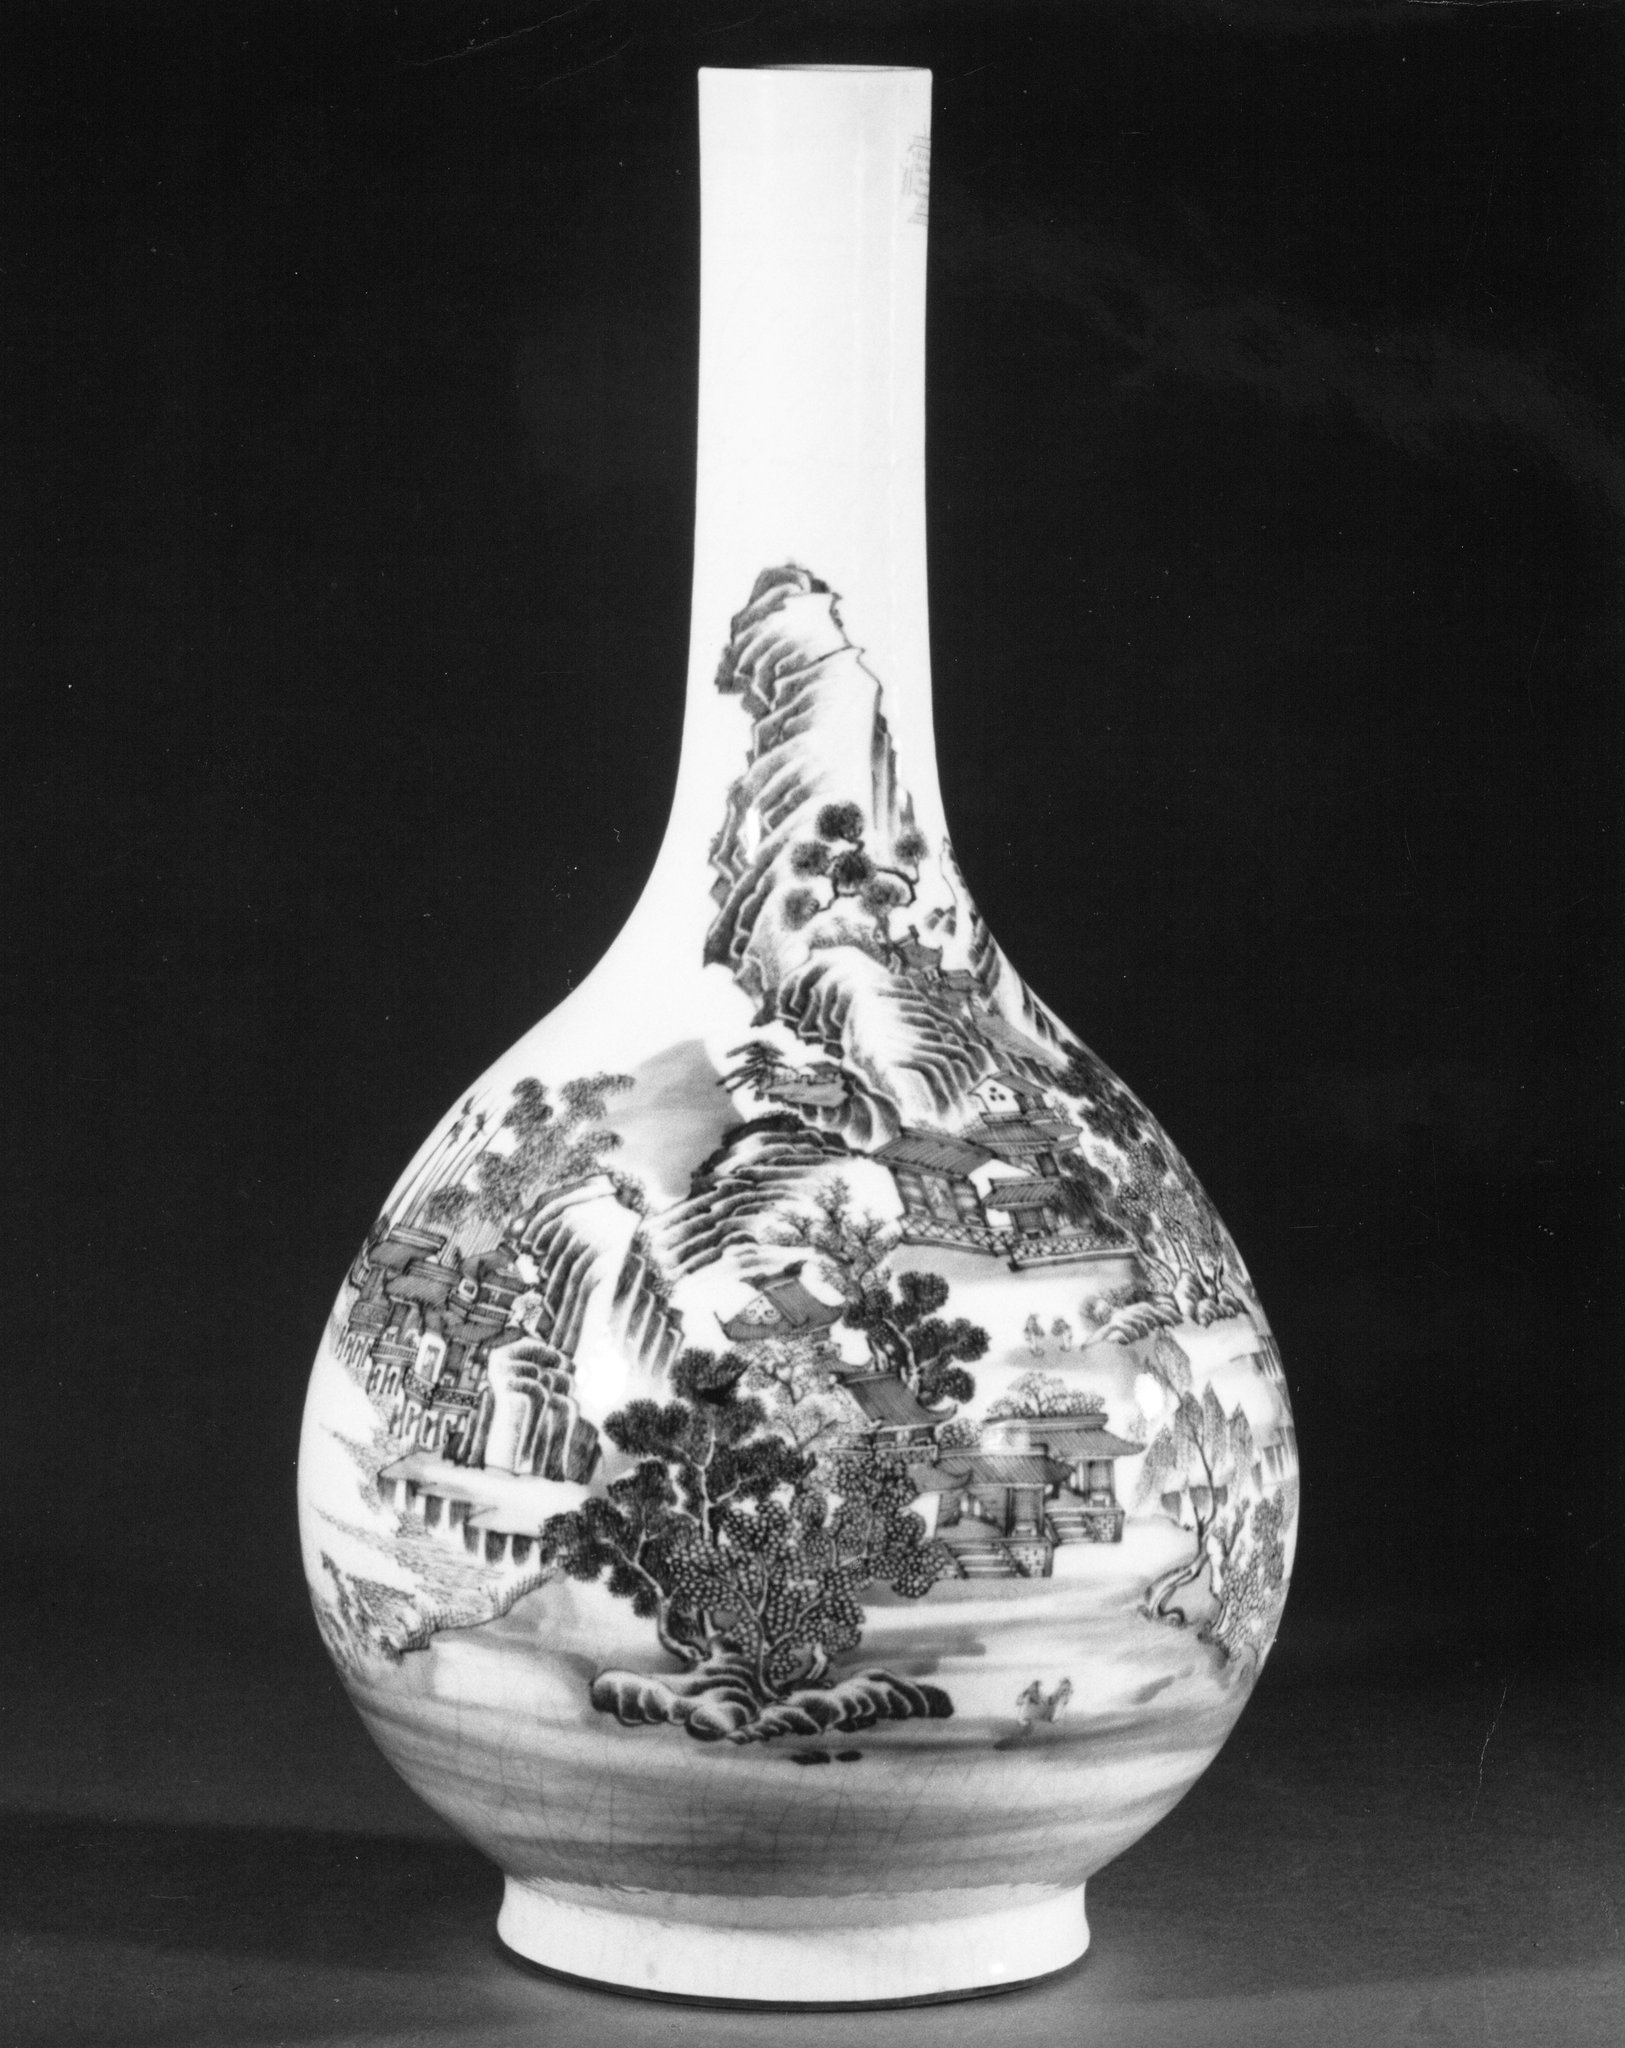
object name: vase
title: Vase with Garden Scene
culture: chinese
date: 1701-1800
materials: cobalt, glaze, paste, porcelain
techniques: painting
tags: buildings,trees